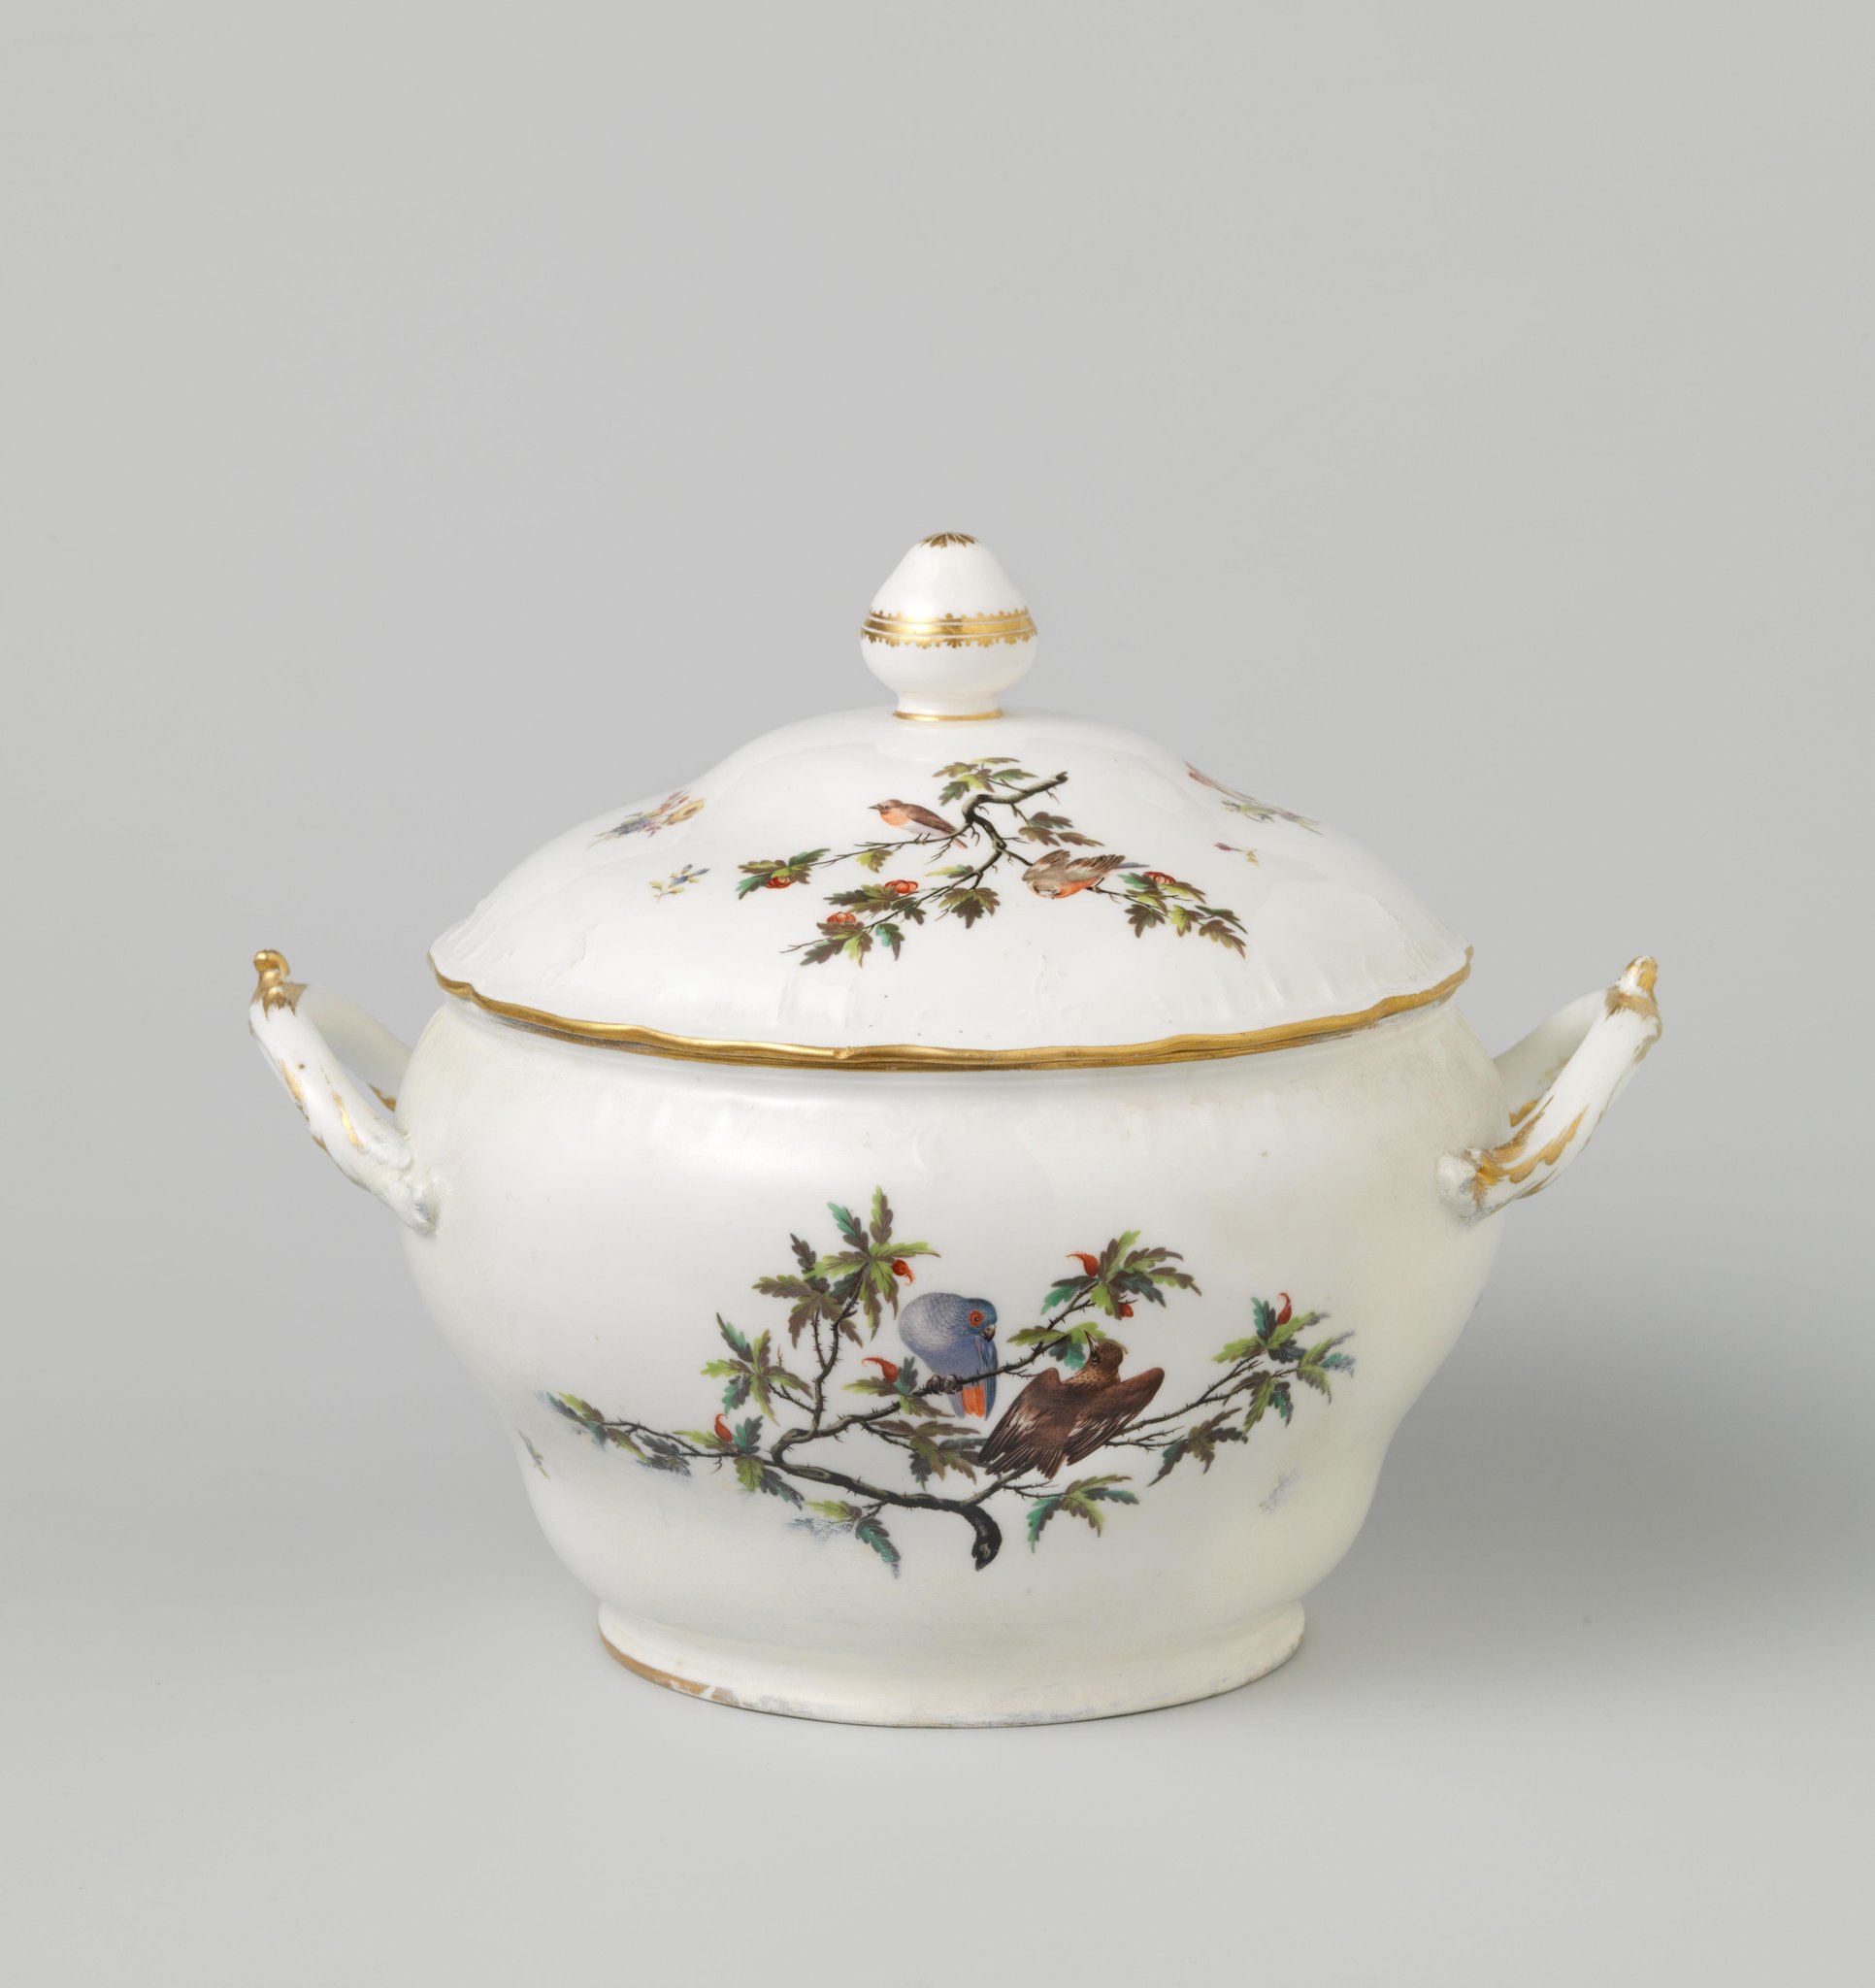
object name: soup tureen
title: Terrine, beschilderd met vruchtentakken en papagaaien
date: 1774-1784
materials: porcelain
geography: loosdrecht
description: Soepterrine van porselein, met deksel. Beschilderd met vruchtentakken met papegaaien.